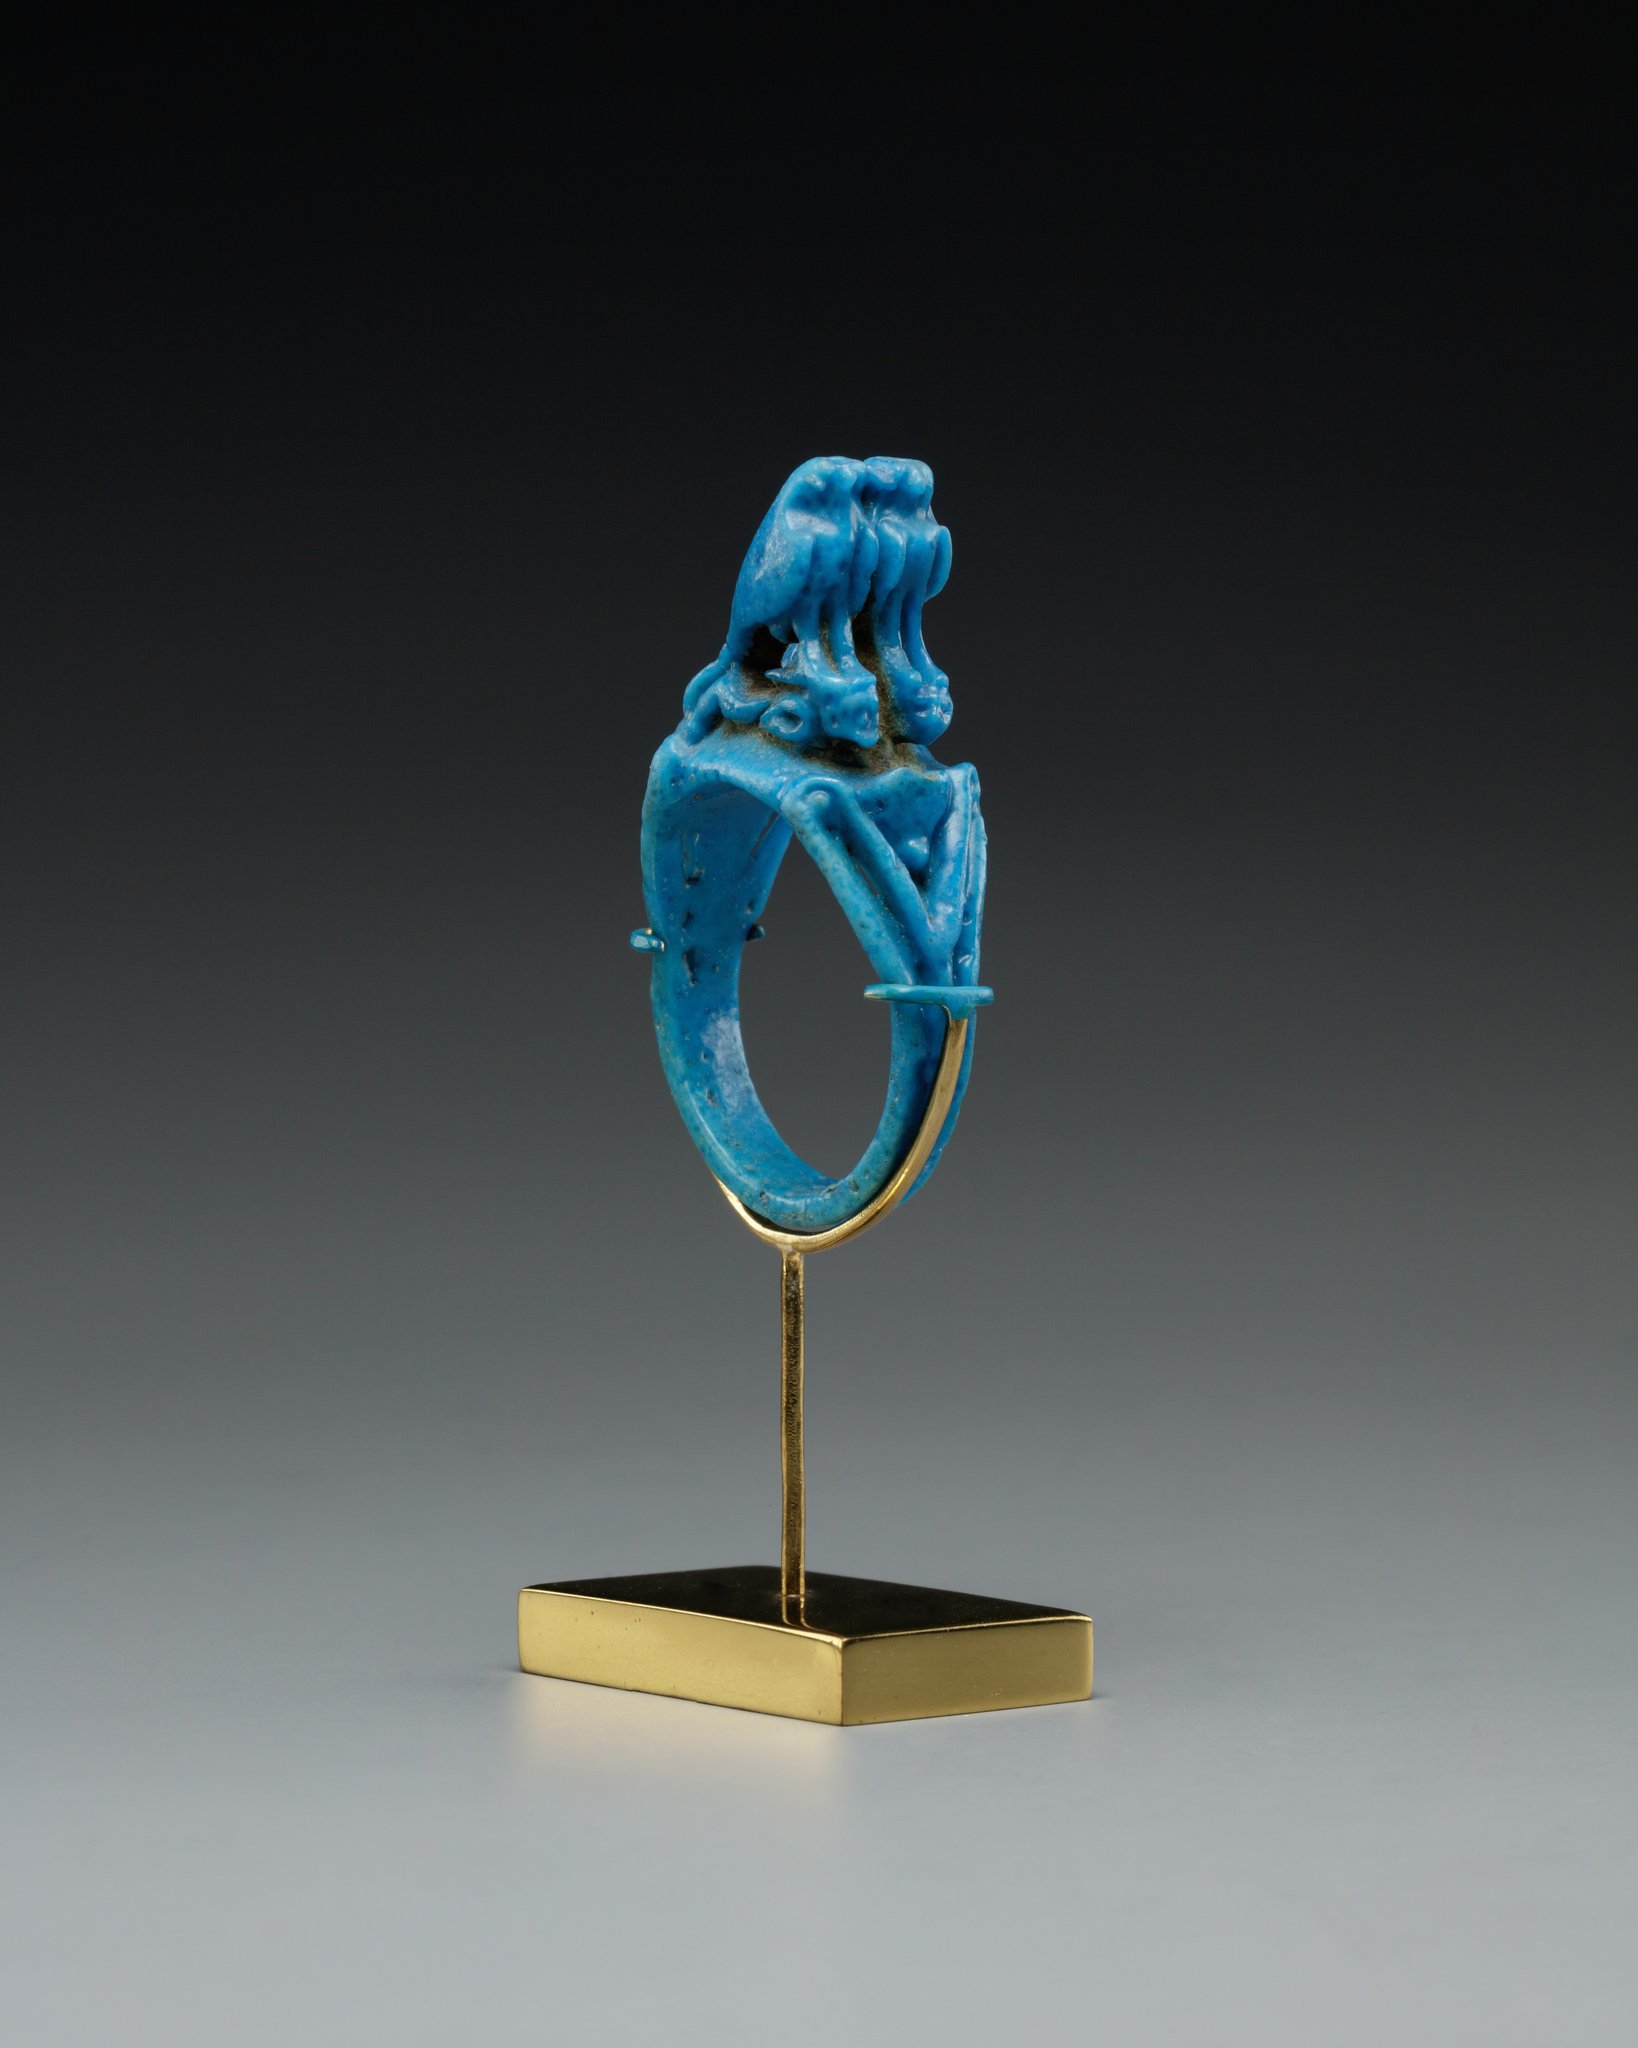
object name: ring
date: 1295-1185 BCE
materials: faience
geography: egypt